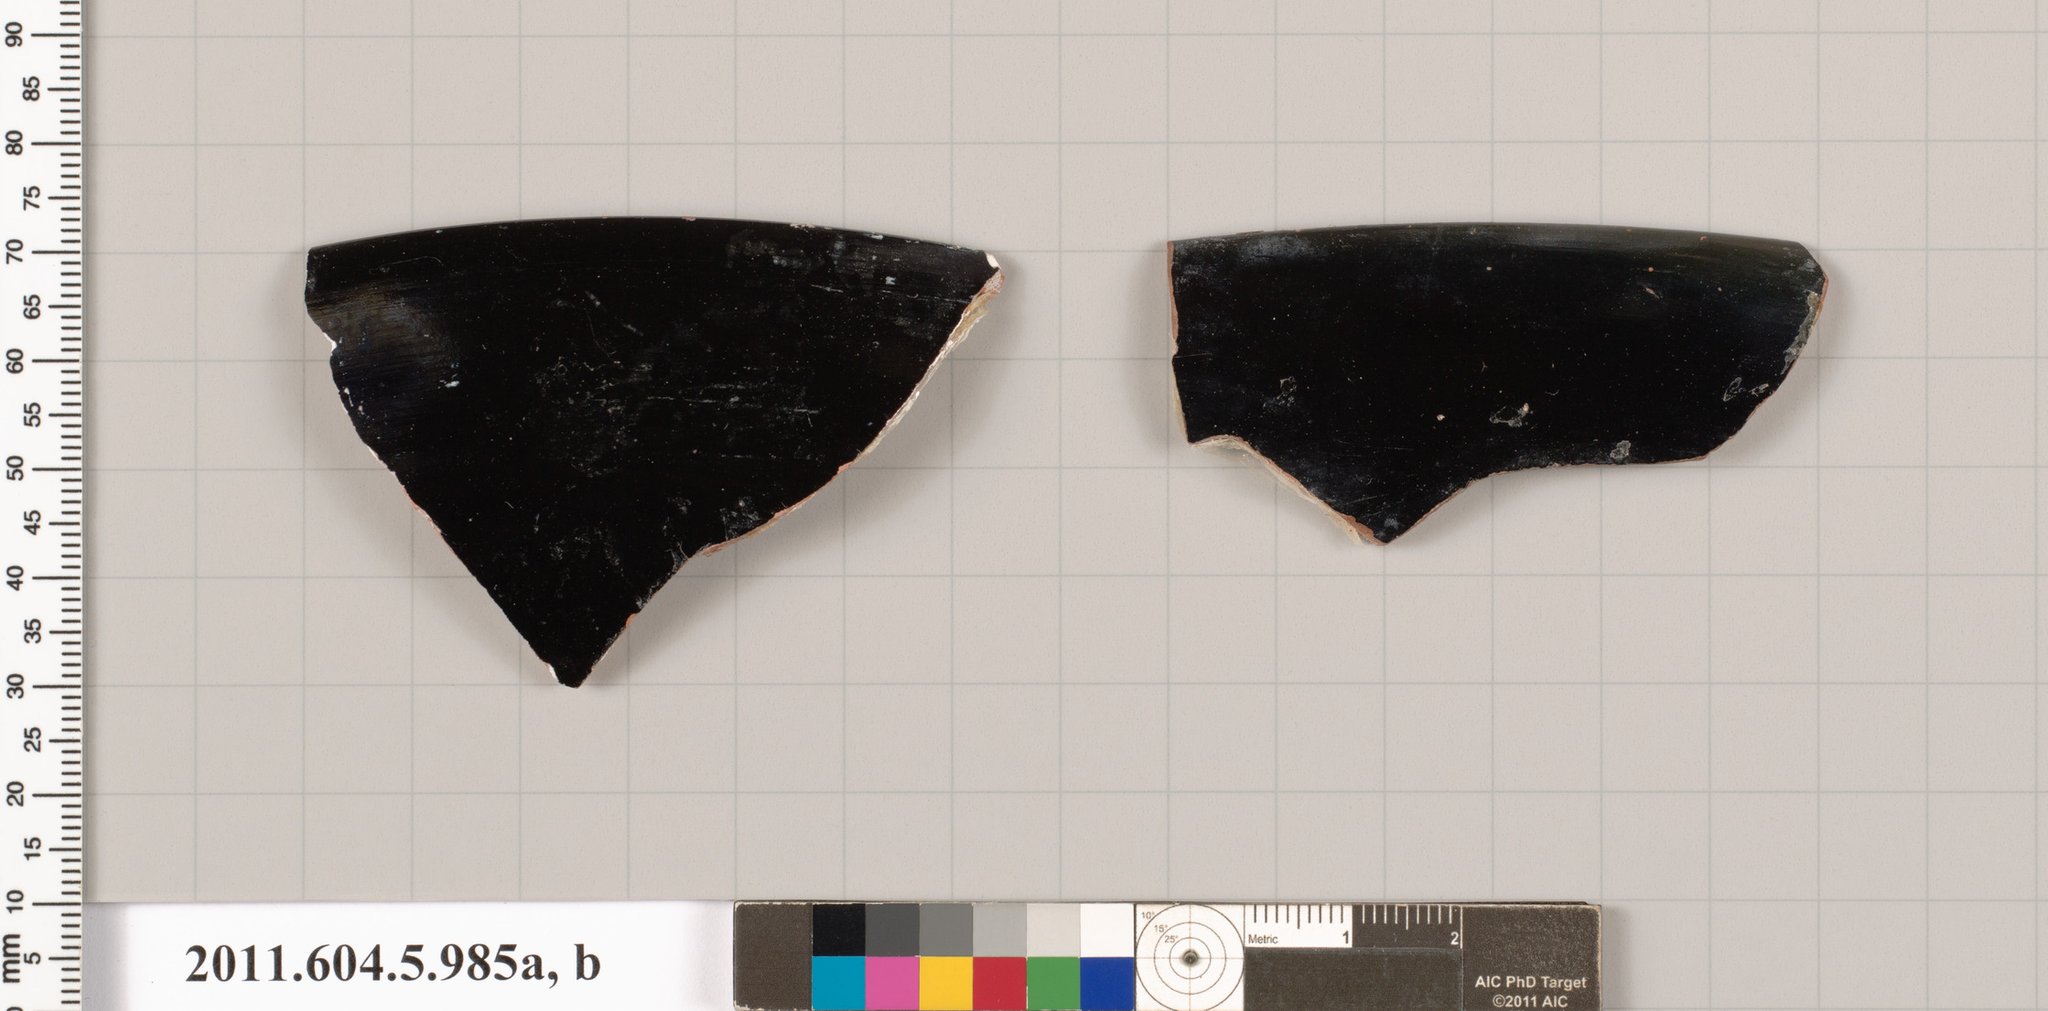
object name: kylix fragment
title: Terracotta rim fragments of kylikes (drinking cups)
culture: greek, attic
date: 600-401 BCE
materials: terracotta